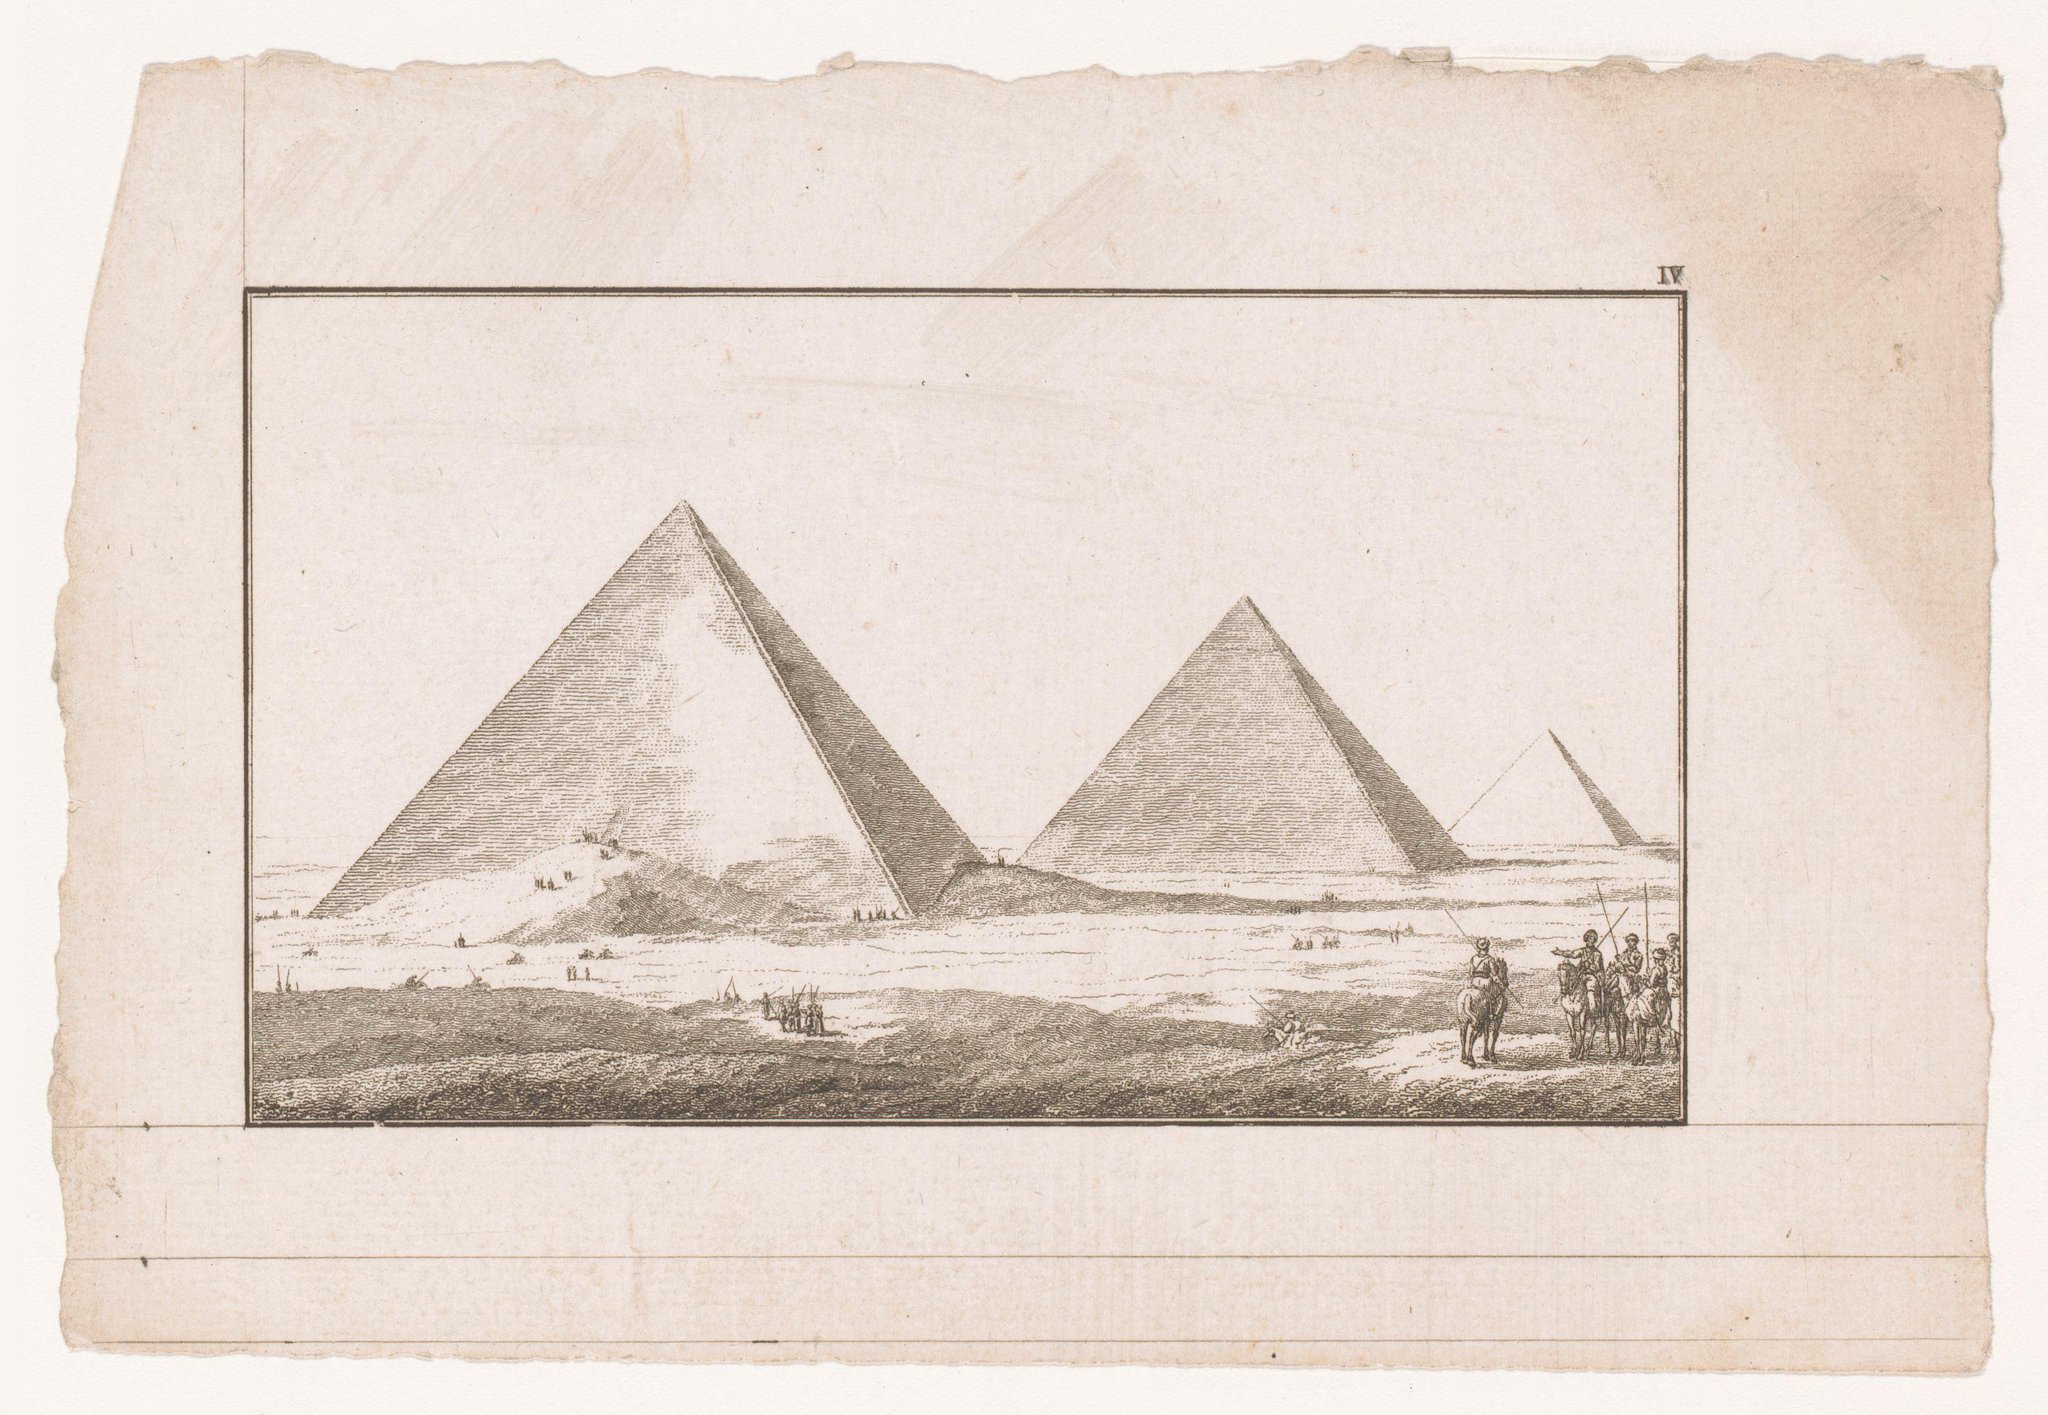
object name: print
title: Gezicht op de Piramiden van Gizeh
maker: Anonymous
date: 1750-1800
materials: paper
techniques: etching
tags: egyptian pyramids (wonder of the world), desert